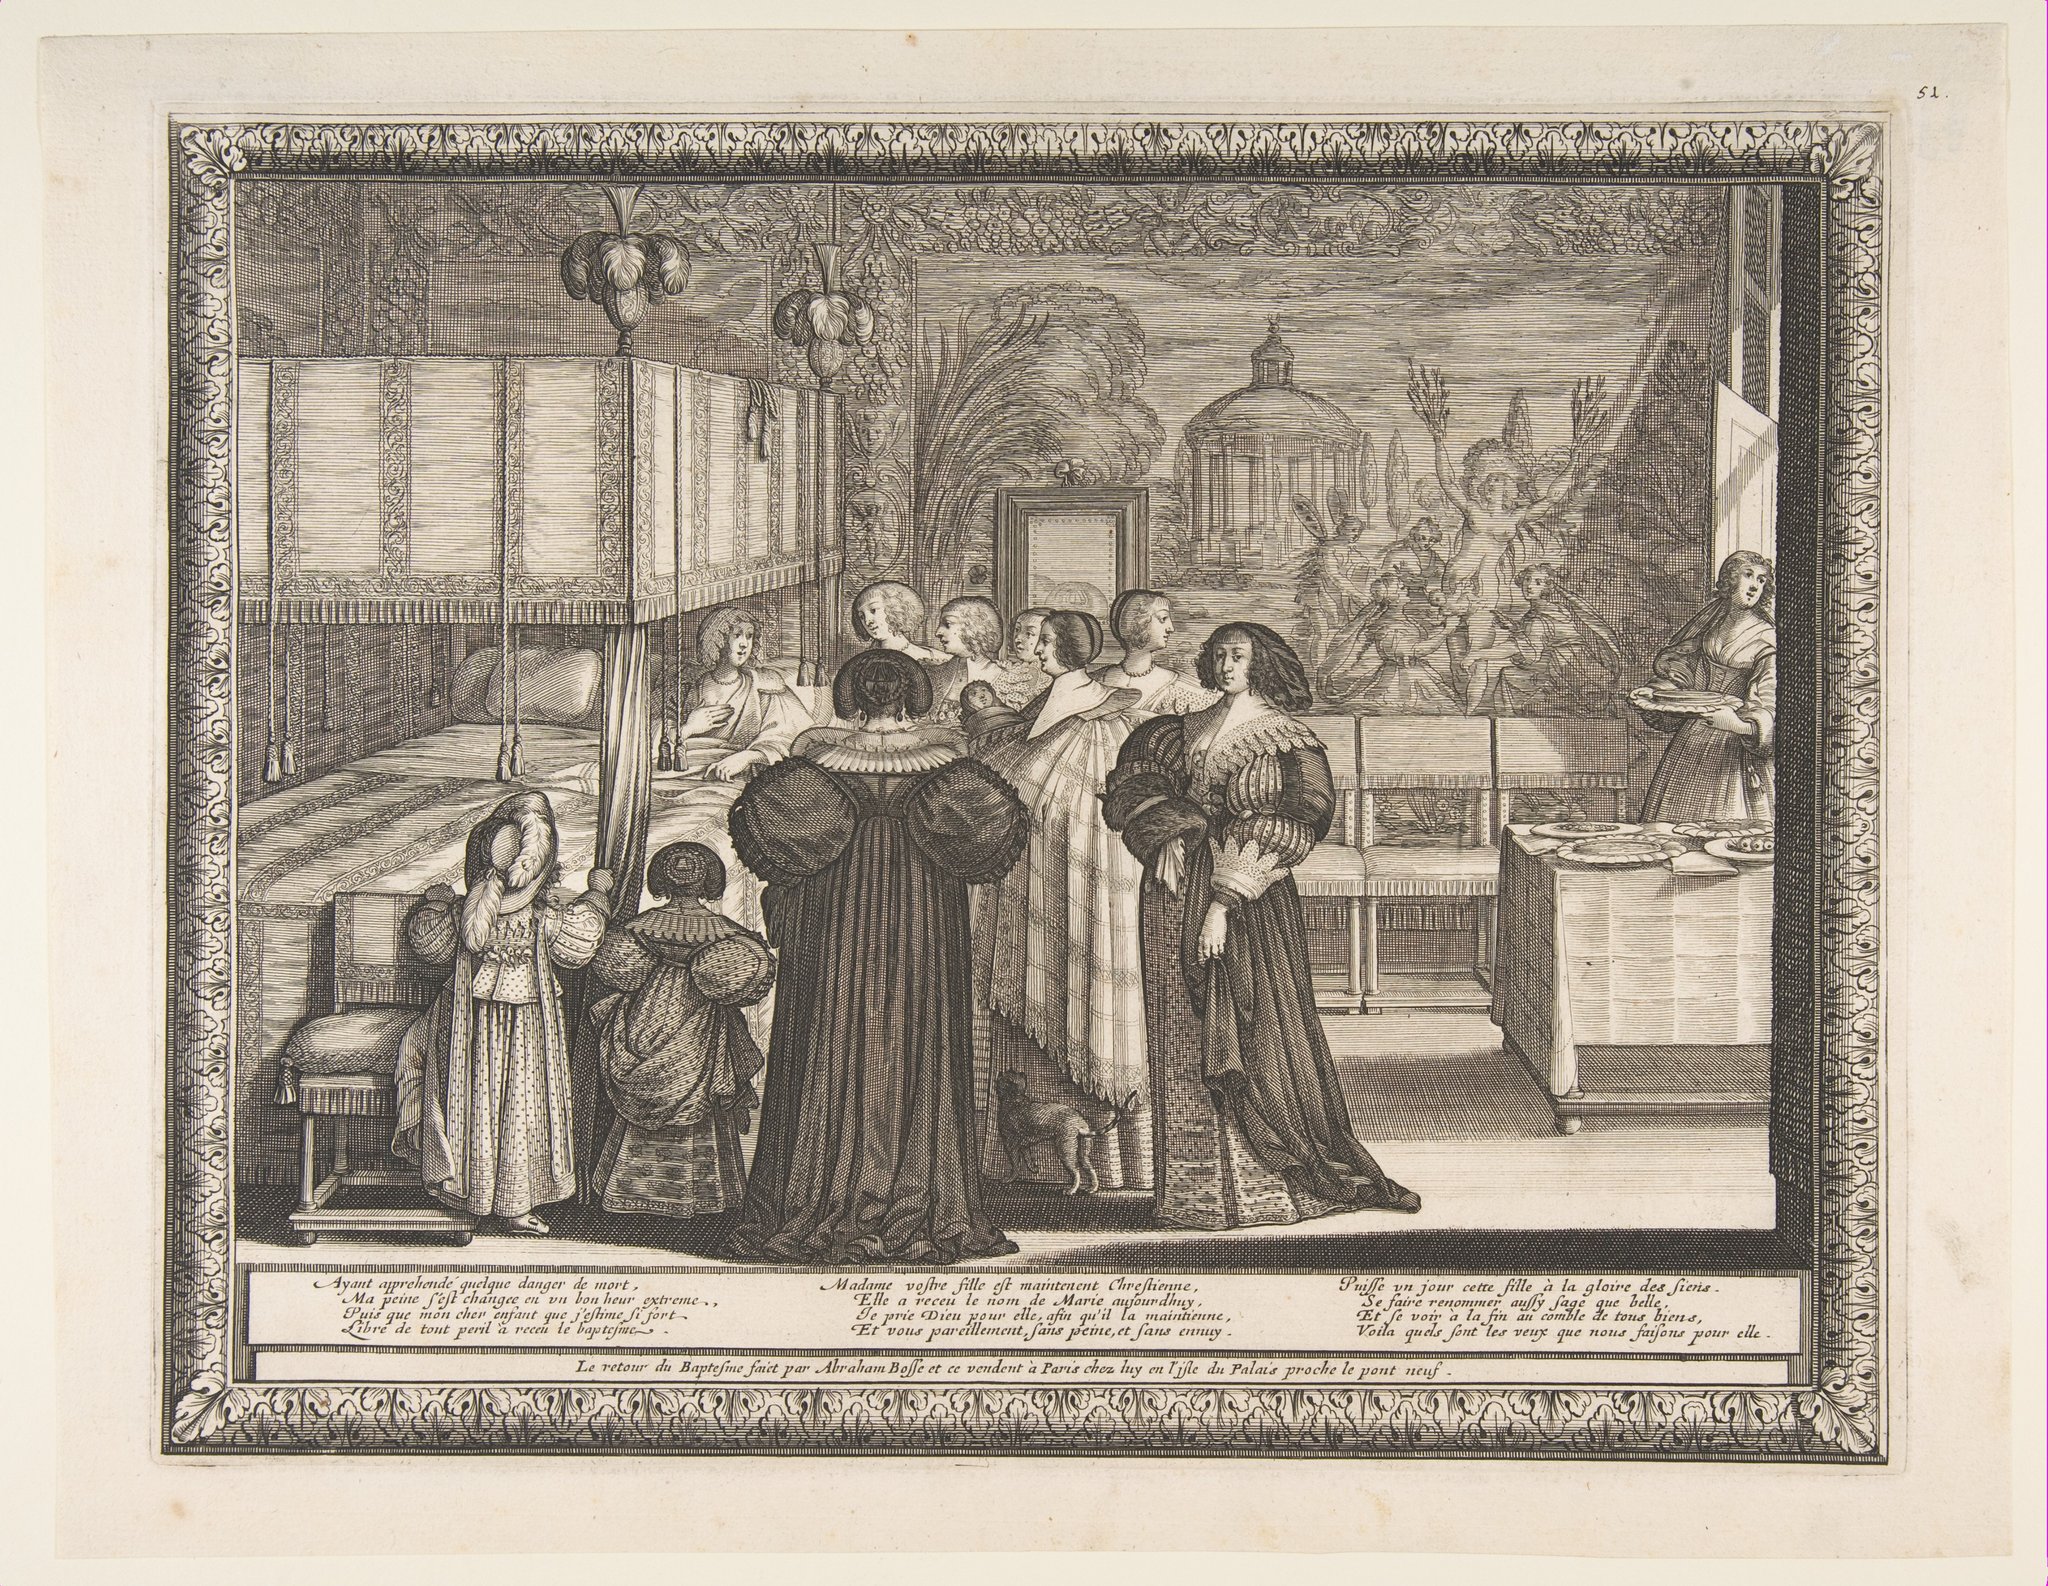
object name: print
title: Return from the Christening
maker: abraham bosse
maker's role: artist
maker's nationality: french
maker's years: 1602-1676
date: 1633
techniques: etching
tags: bedrooms,children,women